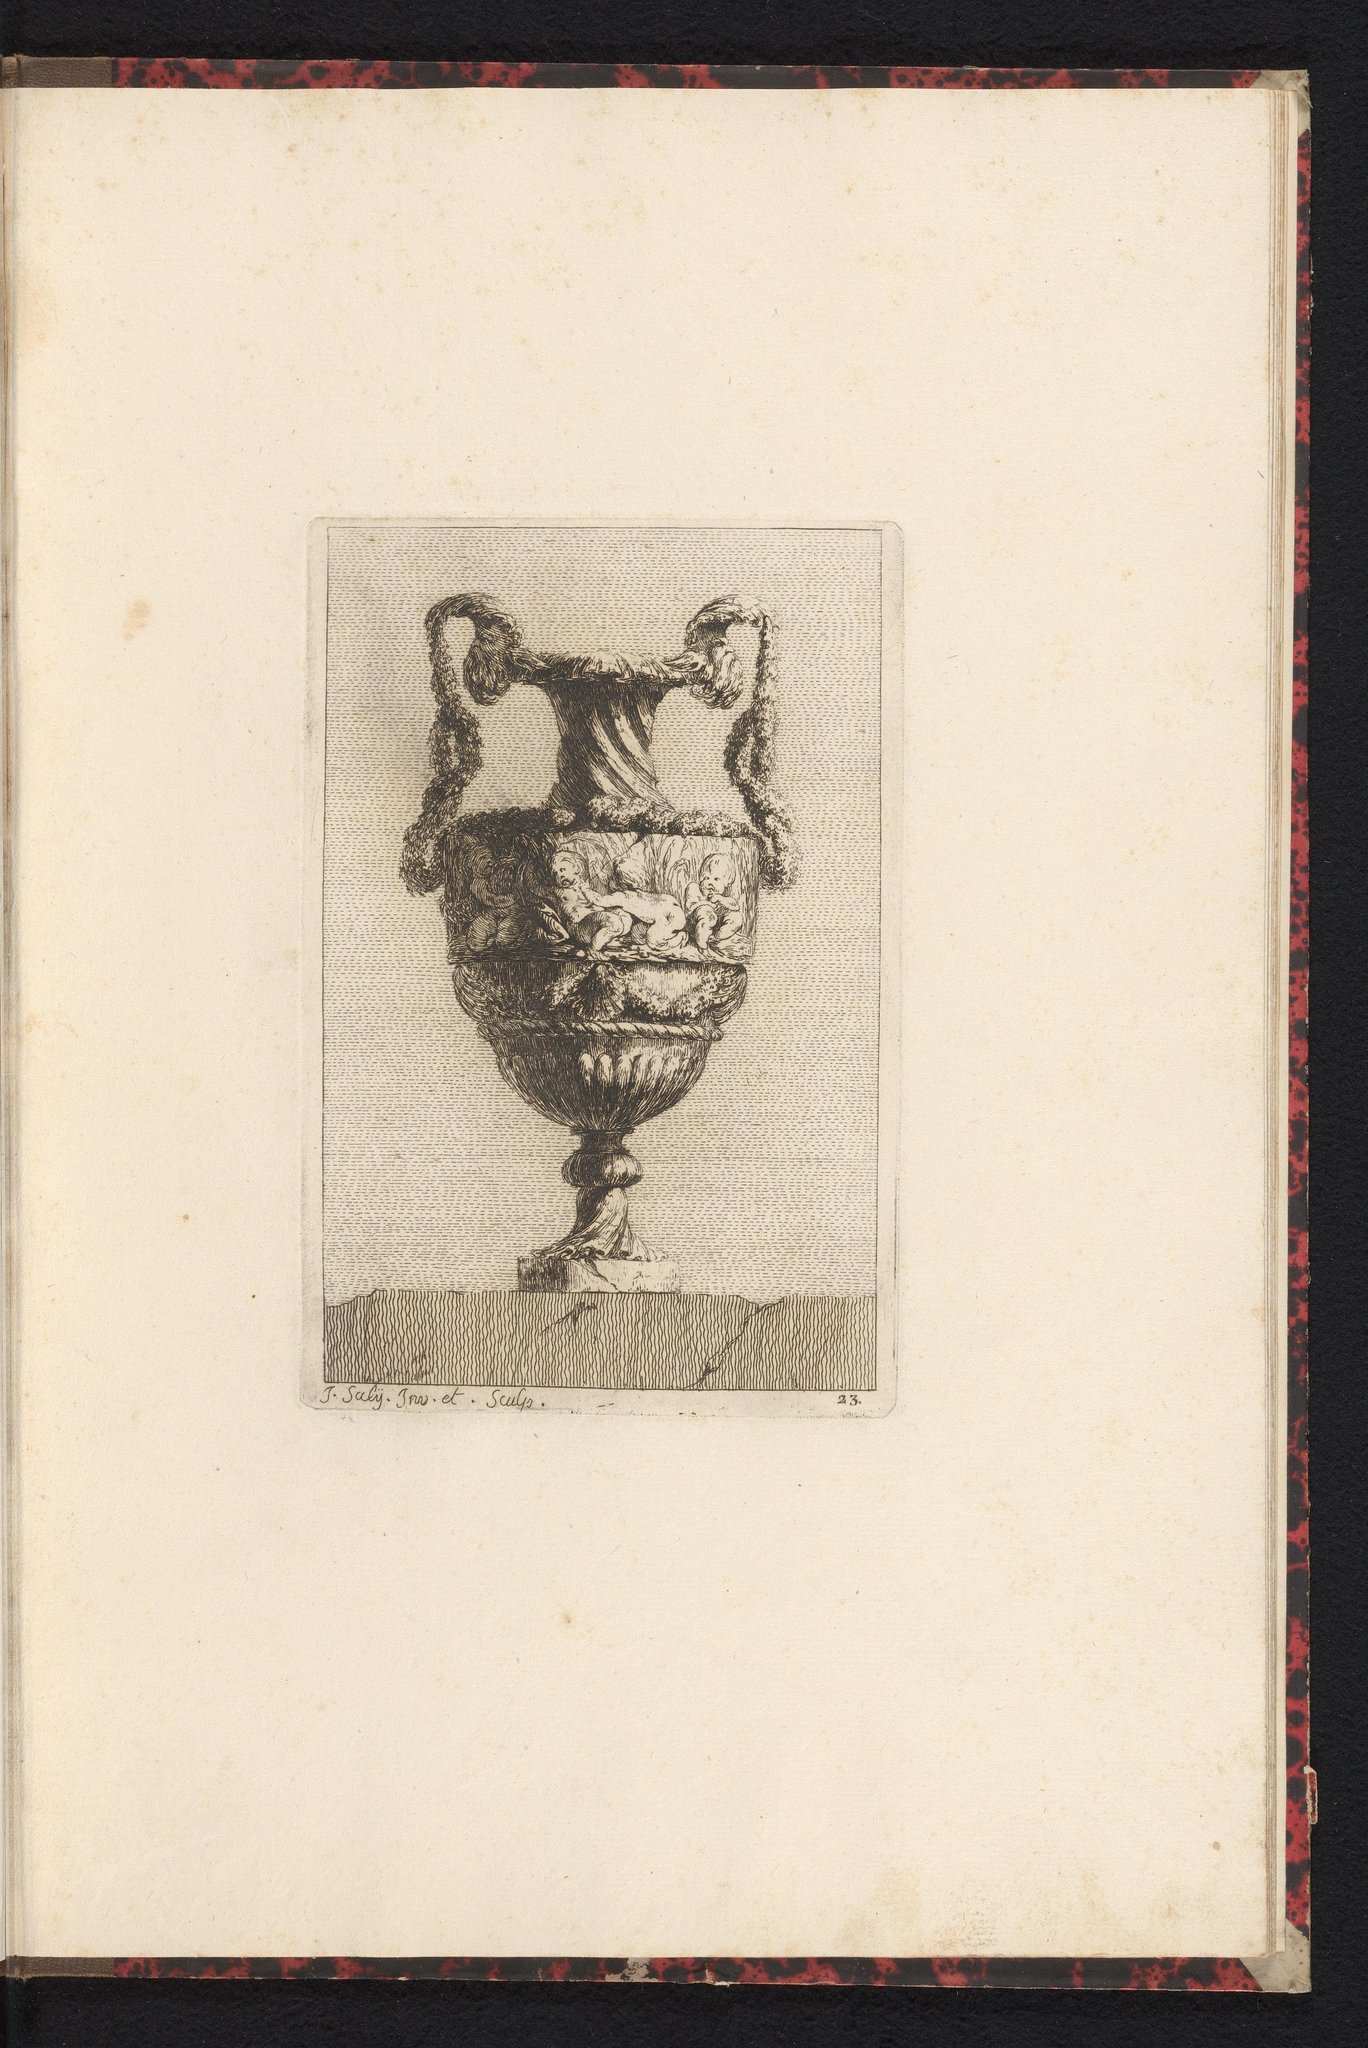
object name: album leaf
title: Vasa a se inventa atq. studii causa delin. et incisa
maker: jacques francois joseph saly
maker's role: print maker, sculptor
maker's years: 1717-1776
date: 1746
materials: paper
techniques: etching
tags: mask, mascaron ~ ornament, ornament ~ festoon, garland, cupids: 'amores', 'amoretti', 'putti', garden vase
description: De oren van de vaas bestaan uit guirlandes voortgezet uit de haardos van van maskers. Deze prent maakt deel uit van een album.